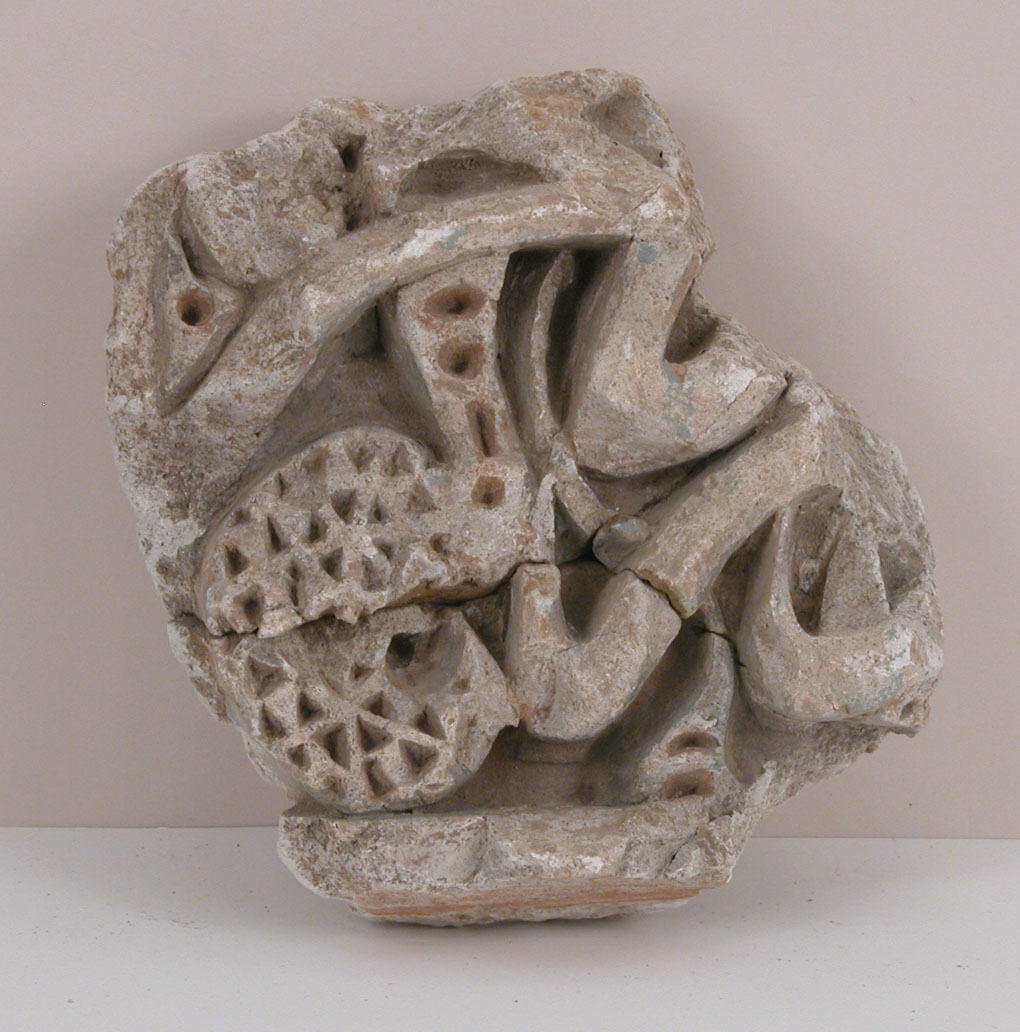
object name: fragment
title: Fragment of a Frieze with Cursive Script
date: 1001-1100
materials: plaster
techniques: carving, painting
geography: iran